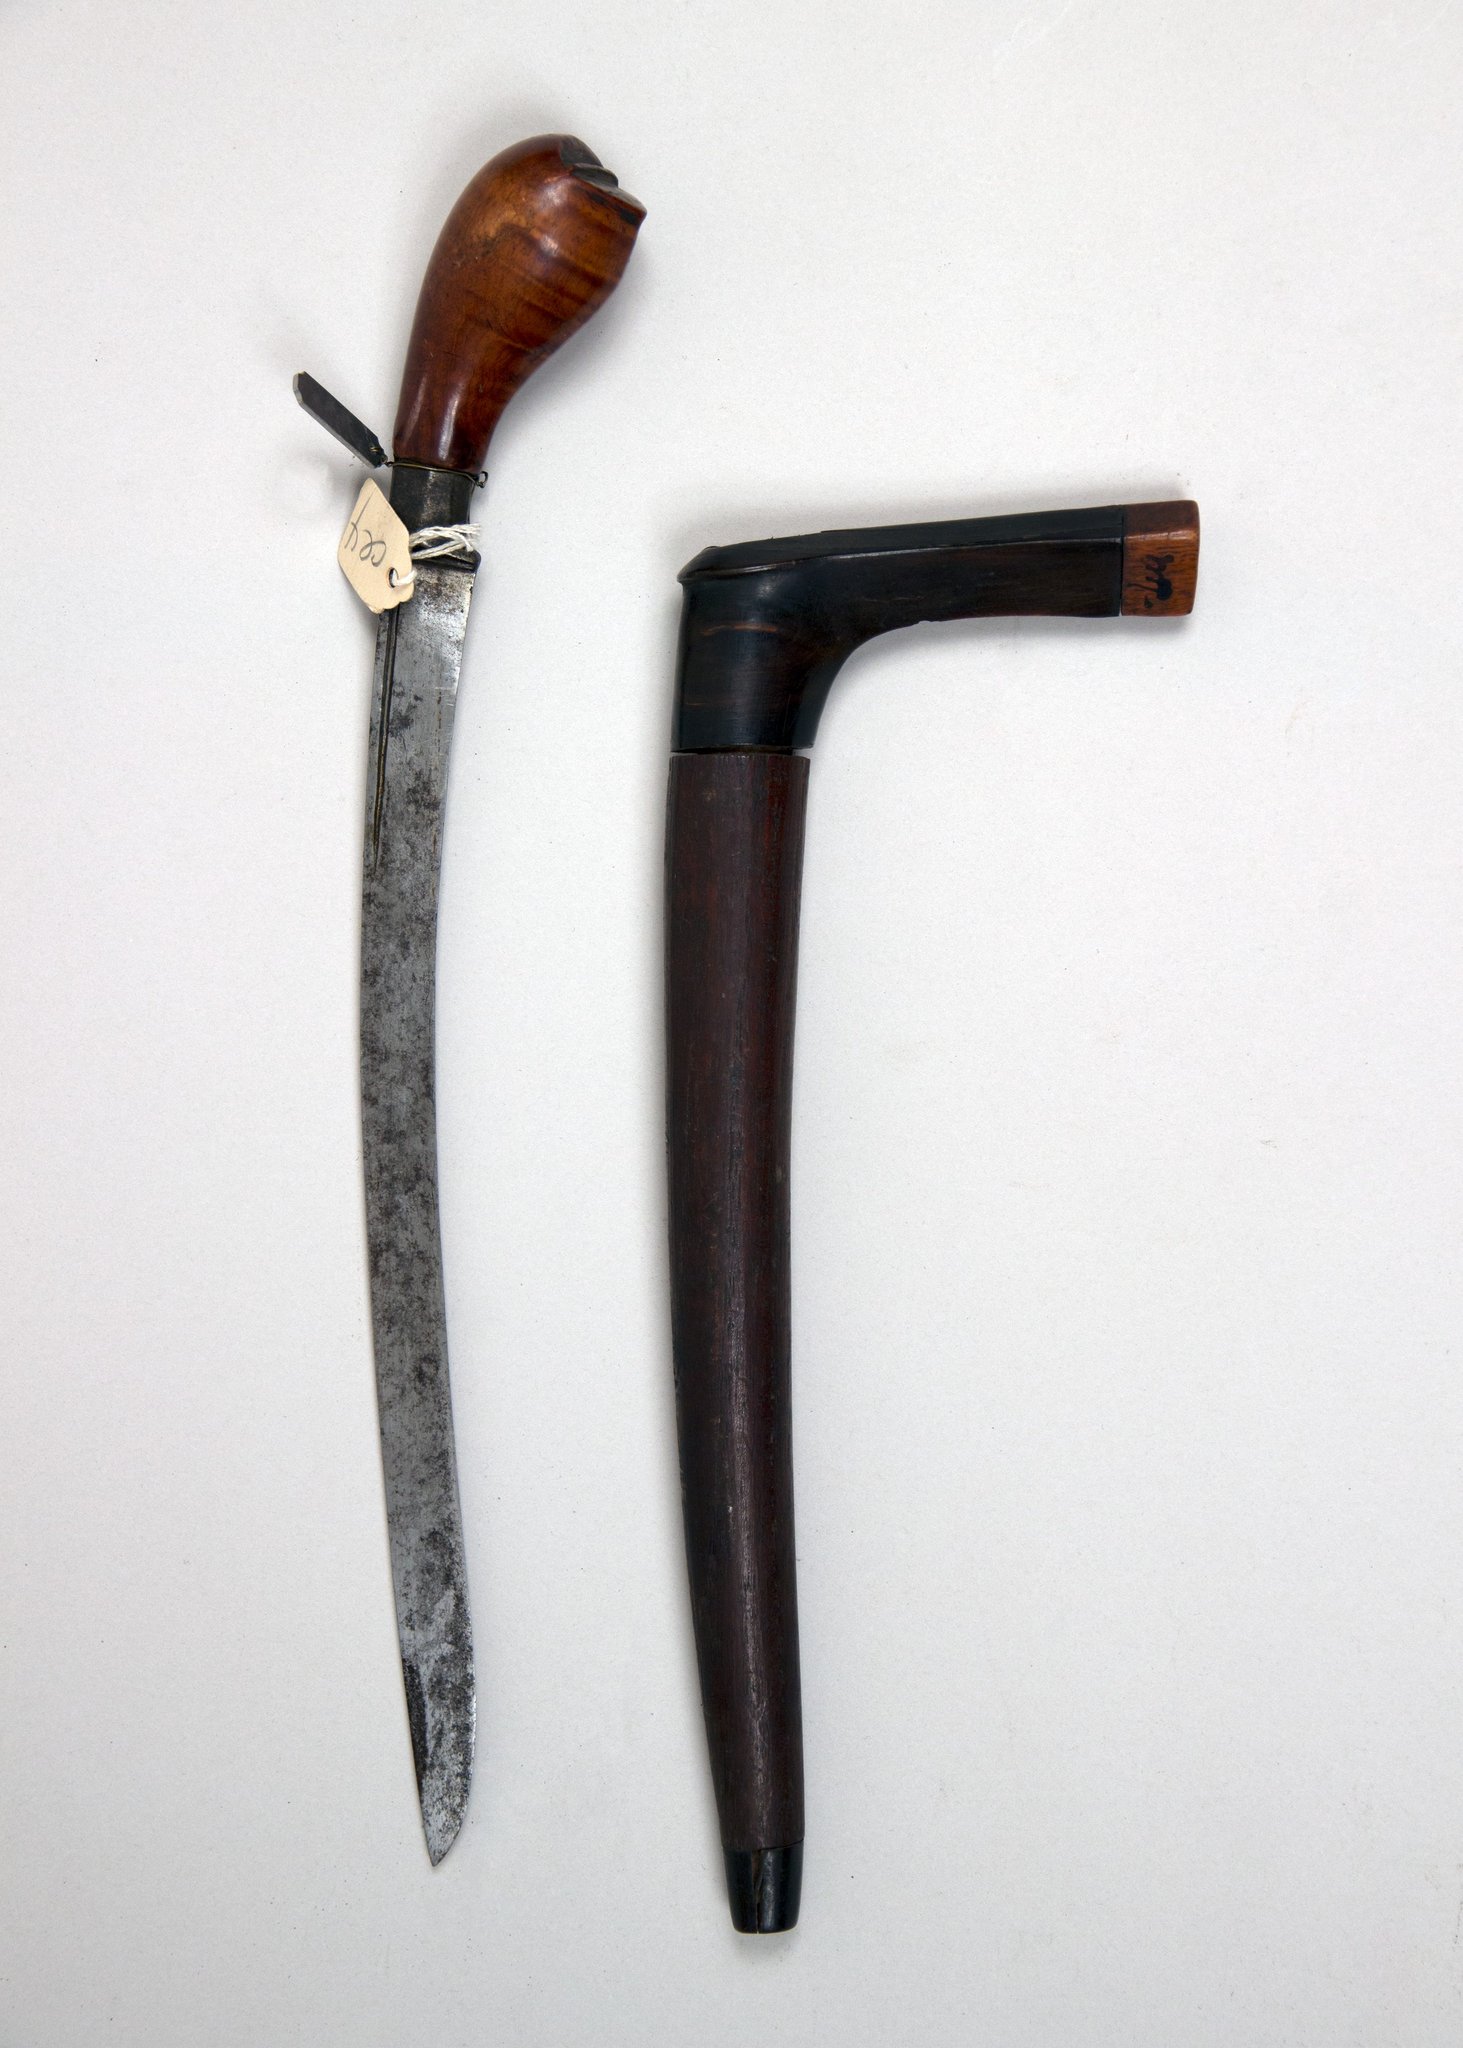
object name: knife bade bade with sheath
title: Knife (Bade-bade) with Sheath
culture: bornean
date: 1701-1900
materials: horn, steel, wood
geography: borneo